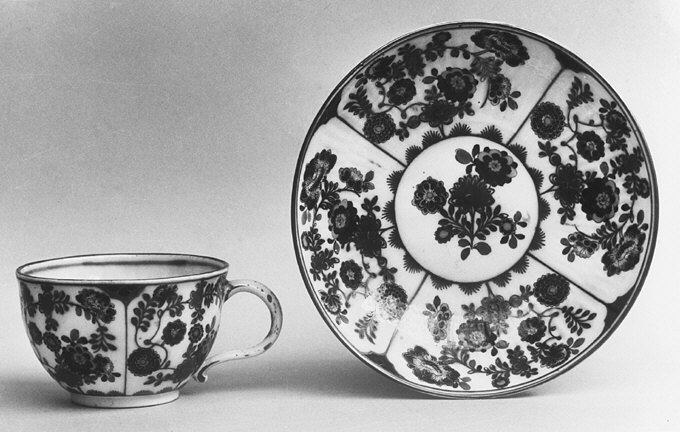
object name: cup and saucer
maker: meissen manufactory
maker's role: manufactory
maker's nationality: german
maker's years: 1710-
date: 1765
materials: hard paste porcelain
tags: flowers